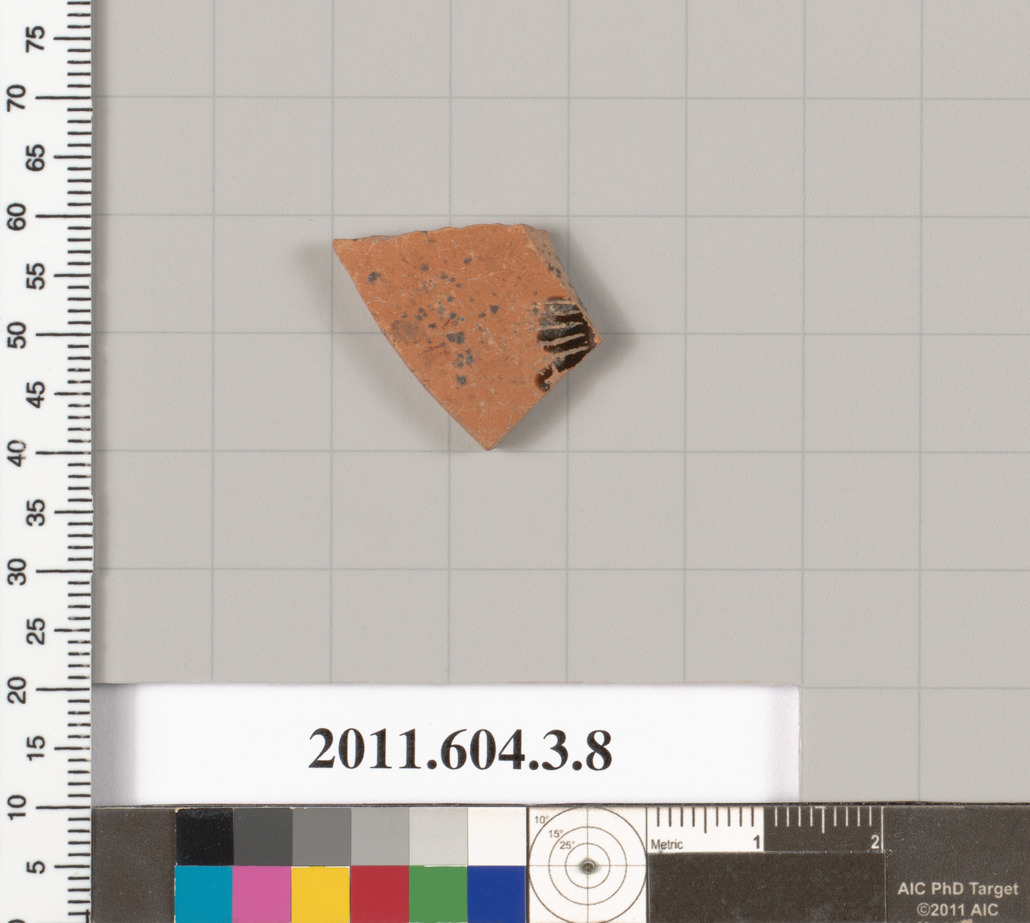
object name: undetermined shape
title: Terracotta fragment of an undetermined shape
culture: greek, attic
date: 534-501 BCE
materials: terracotta